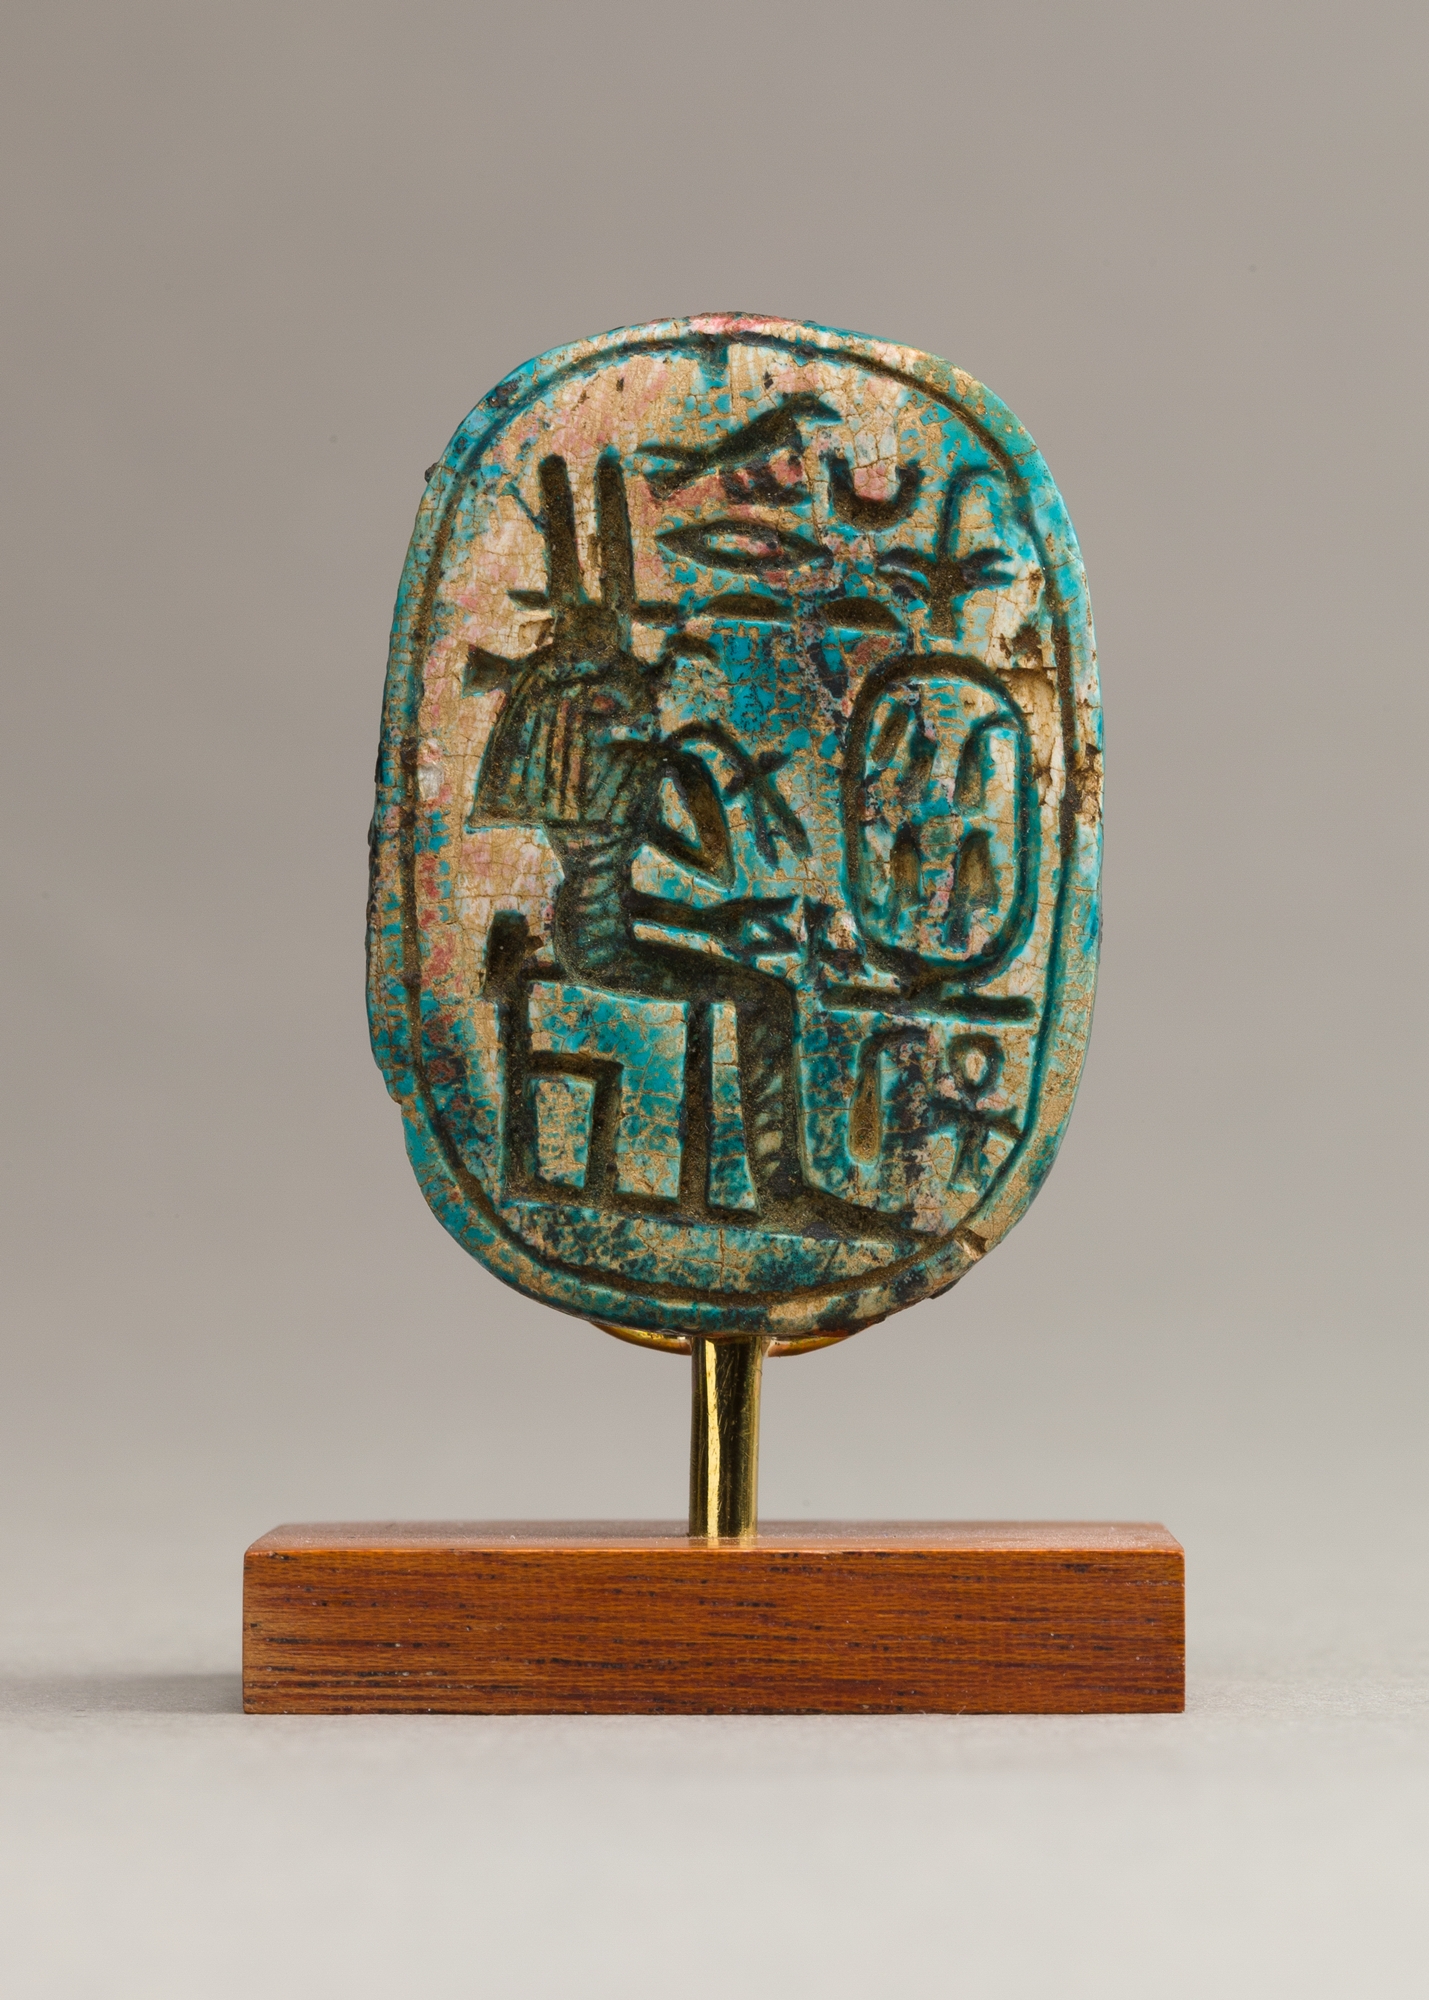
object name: scarab, queen tiye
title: Scarab Depicting Queen Tiye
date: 1390-1352 BCE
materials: stone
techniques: glazing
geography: egypt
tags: queens,hieroglyphs,scarabs